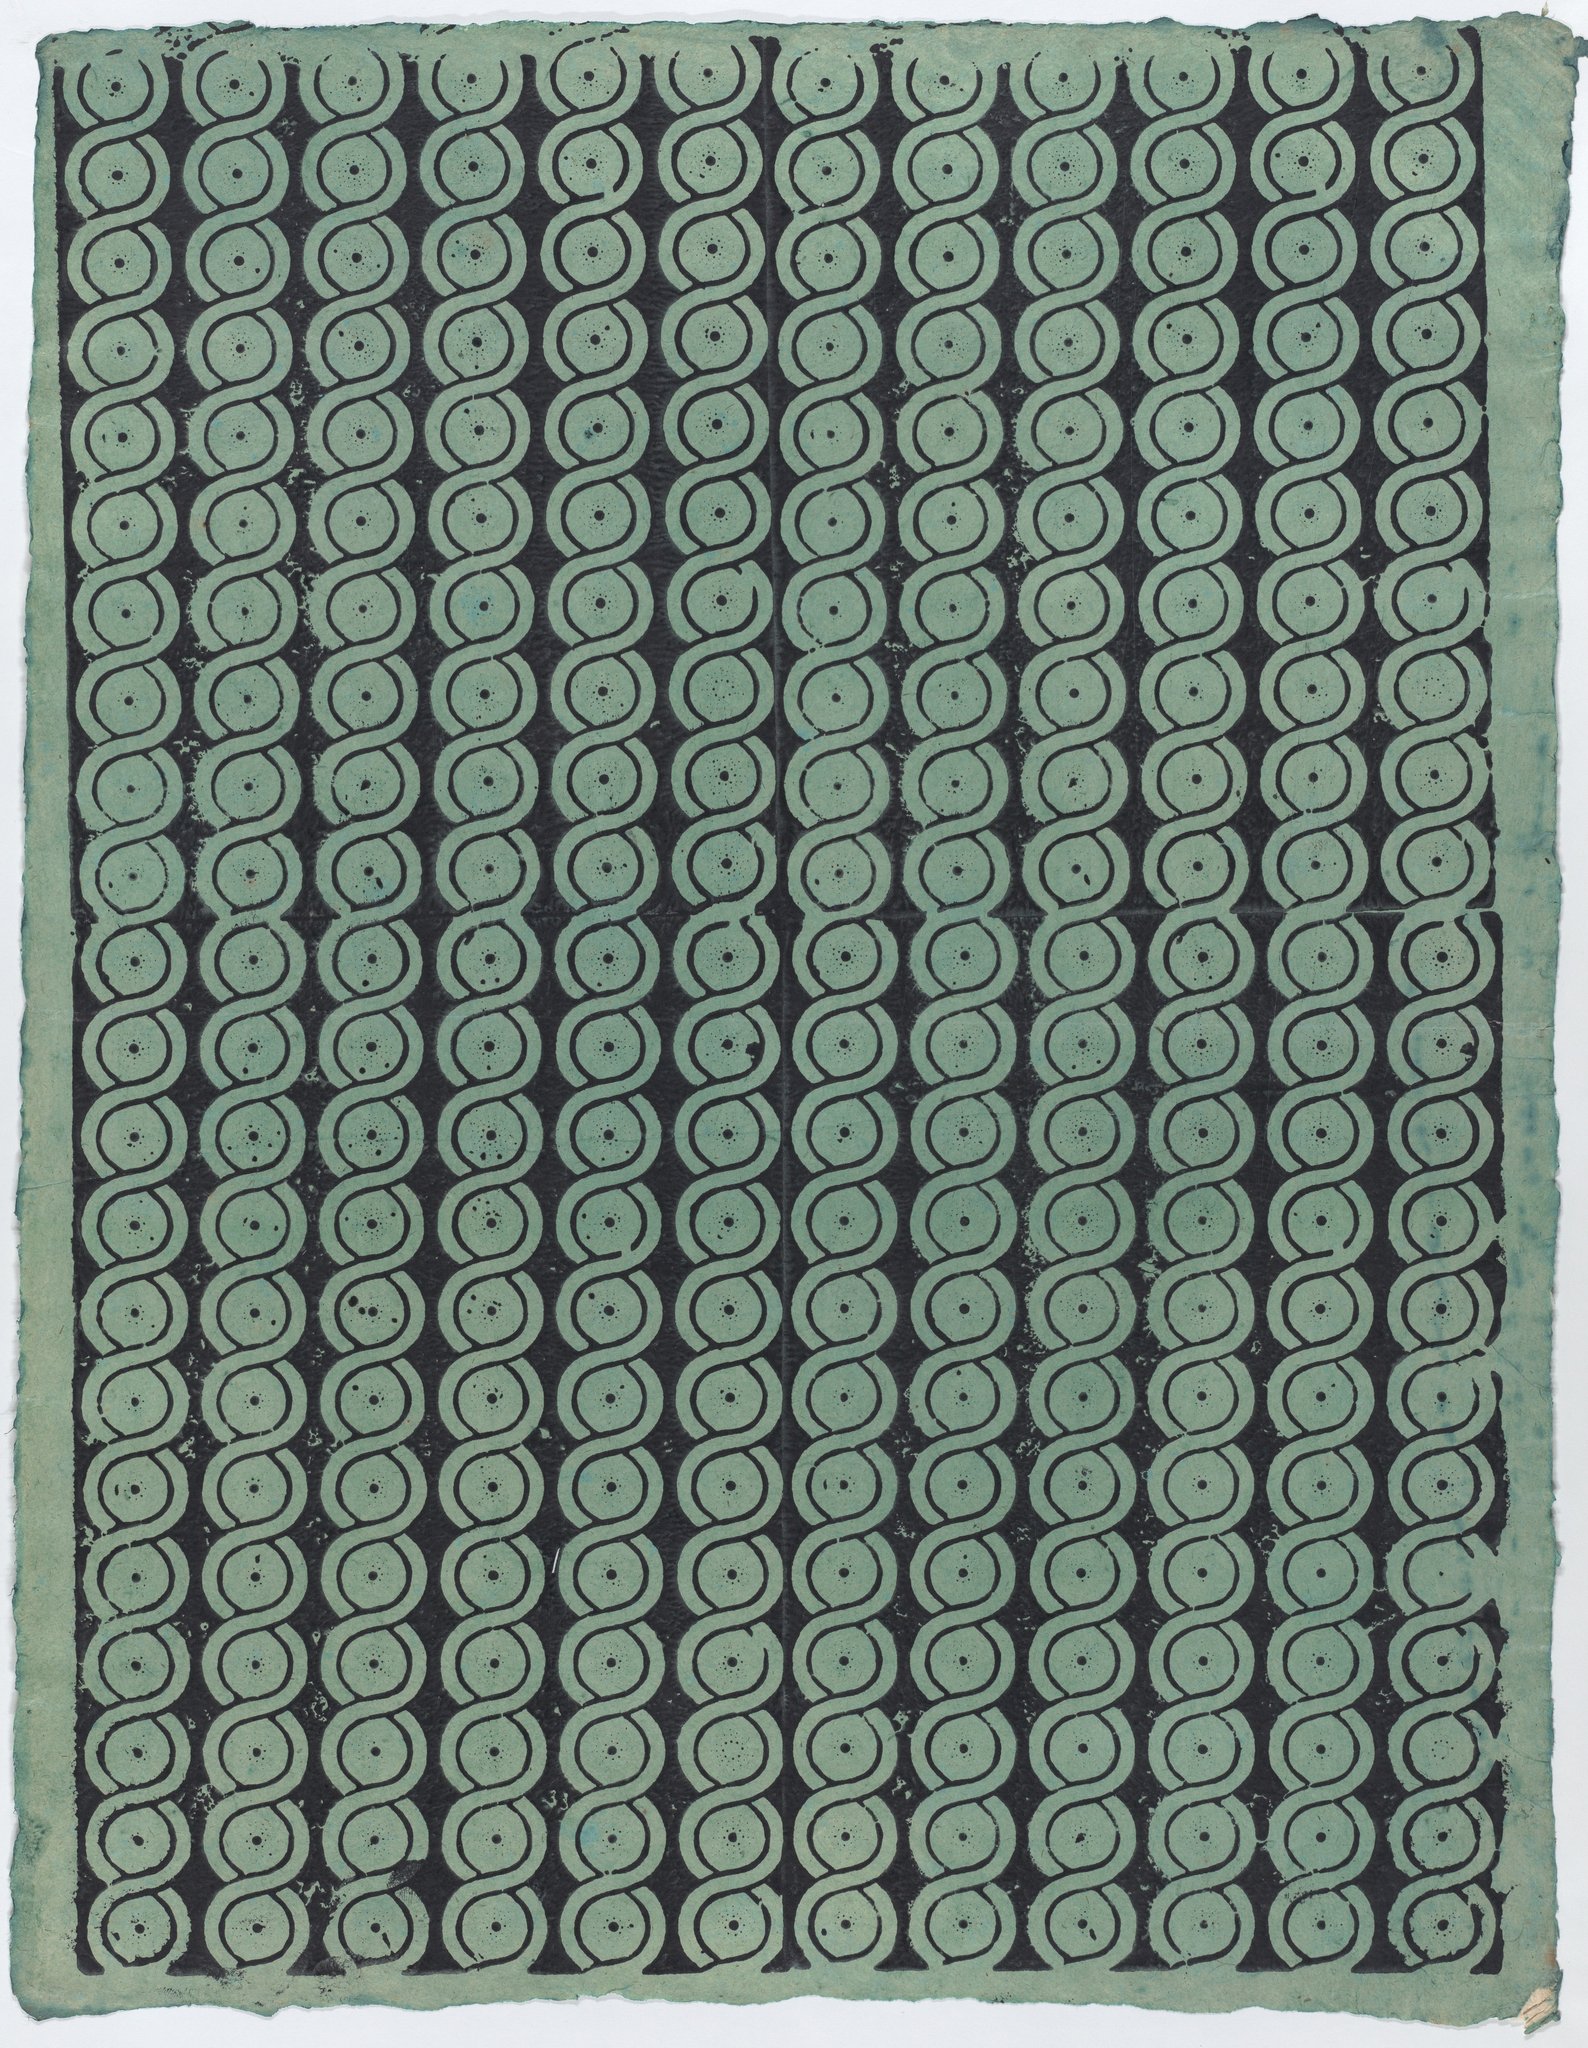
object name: print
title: Sheet with overall guilloche pattern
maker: Anonymous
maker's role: artist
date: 1767-1866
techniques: relief print